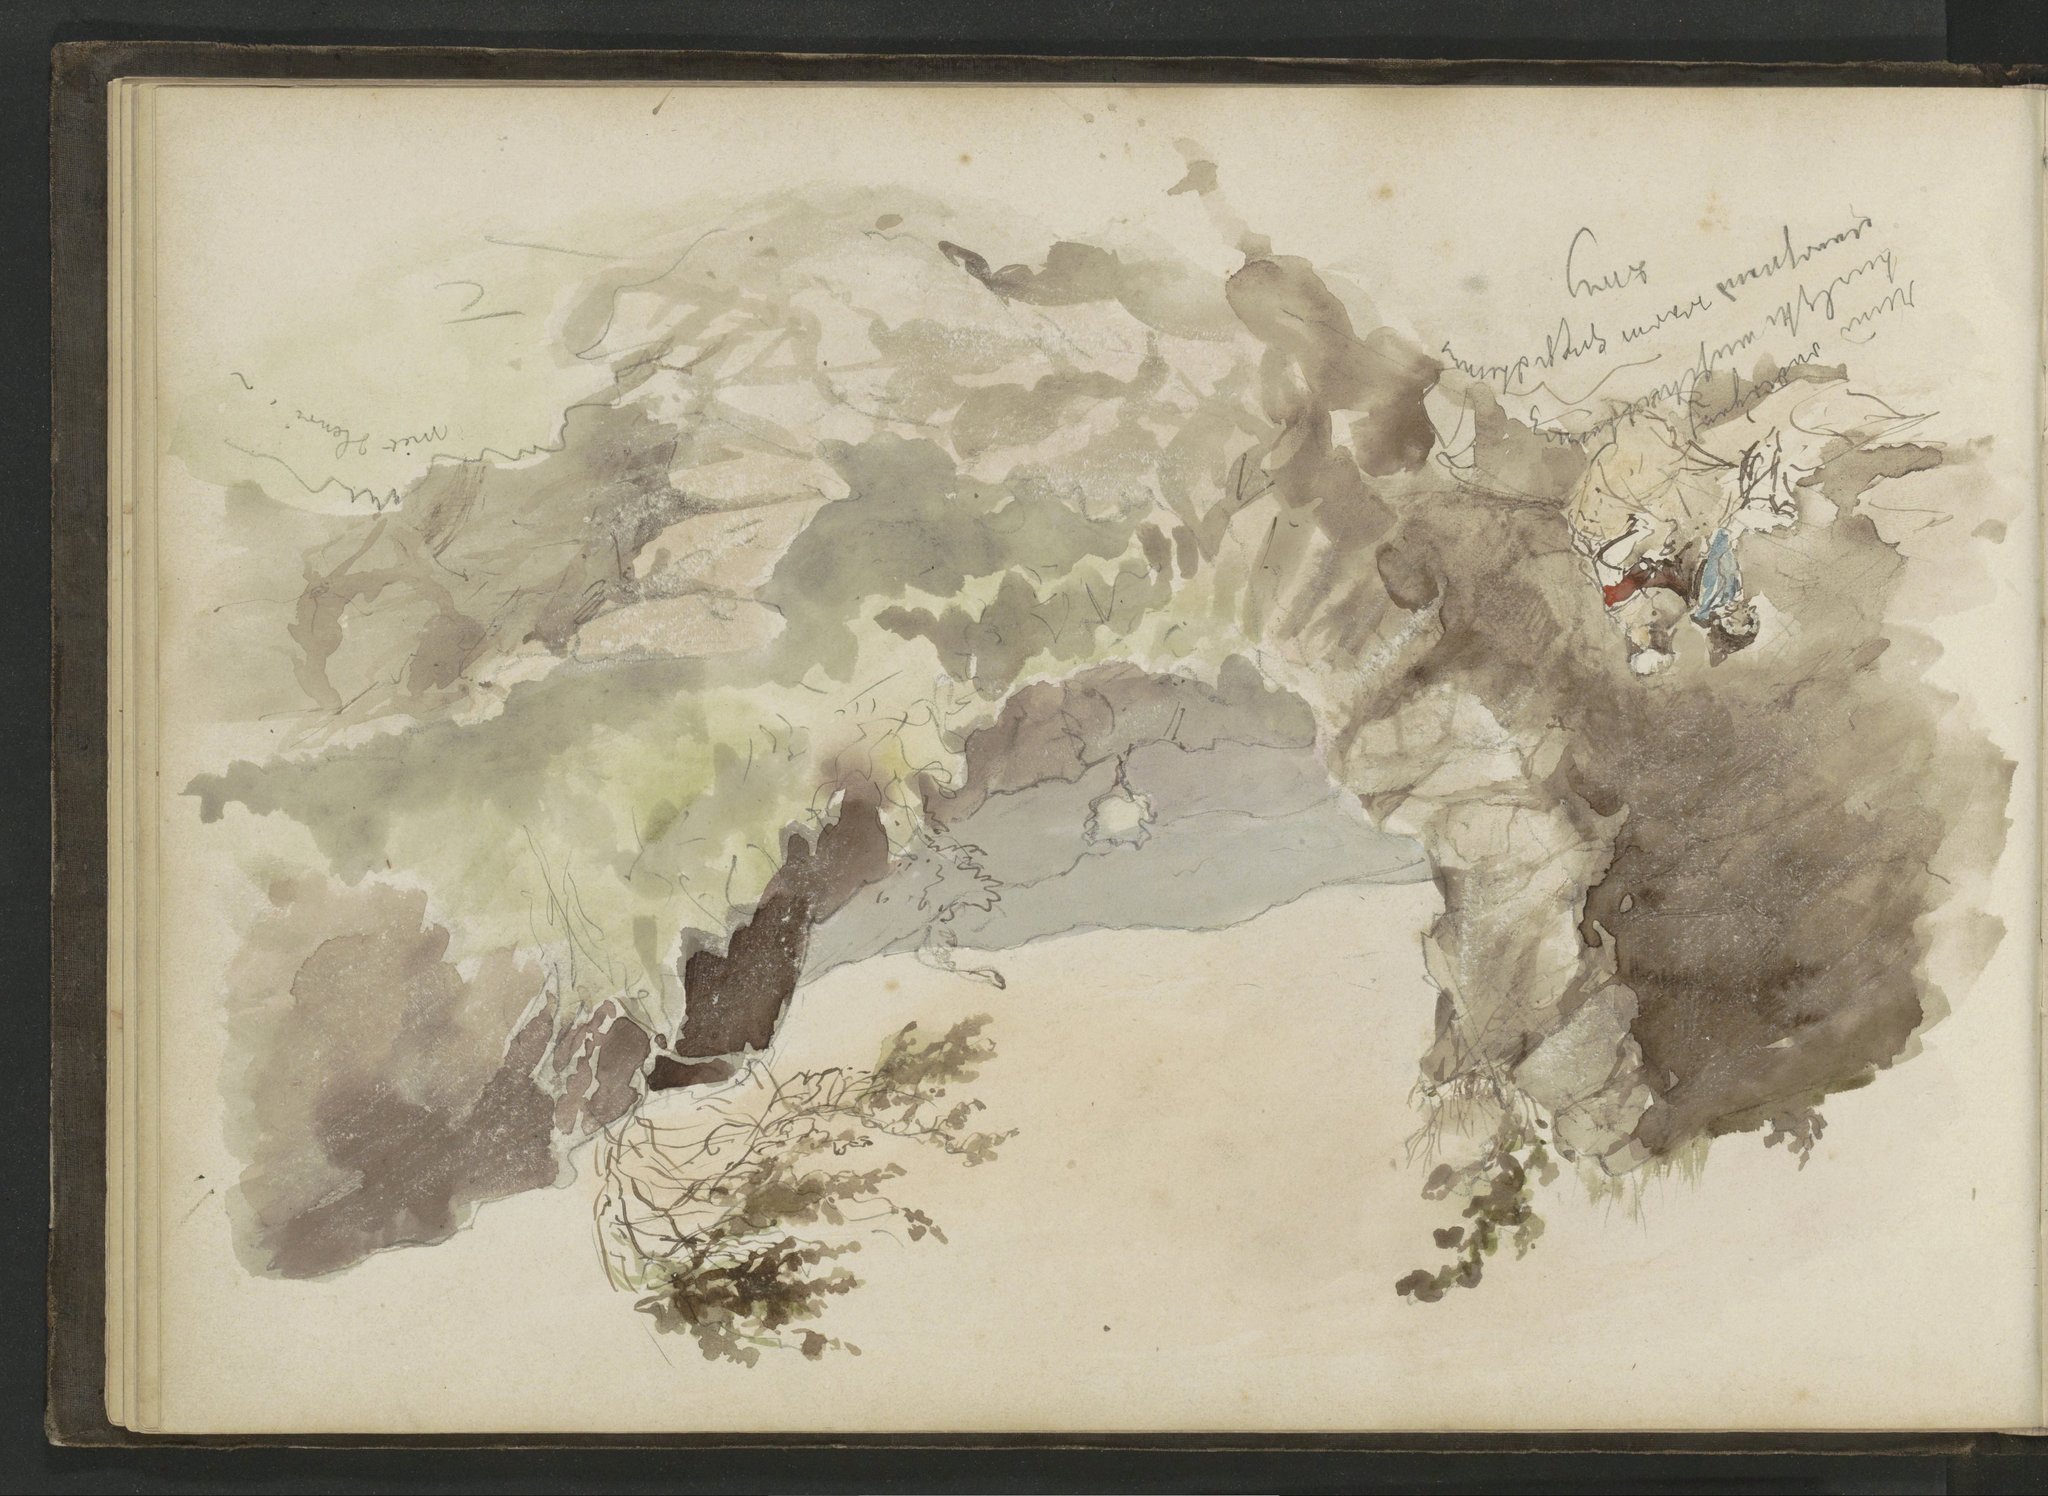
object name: sketchbook leaf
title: Twee zittende figuren in een berglandschap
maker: johannes tavenraat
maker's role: draughtsman, painter, print maker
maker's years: 1809-1881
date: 1861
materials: ink, paper, pencil, watercolor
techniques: brush, pen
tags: forest, wood, landscapes (+ landscape with figures, staffage), mountains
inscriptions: annotation: ‘met Henri’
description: Blad 24 verso uit een schetsboek met 57 bladen.